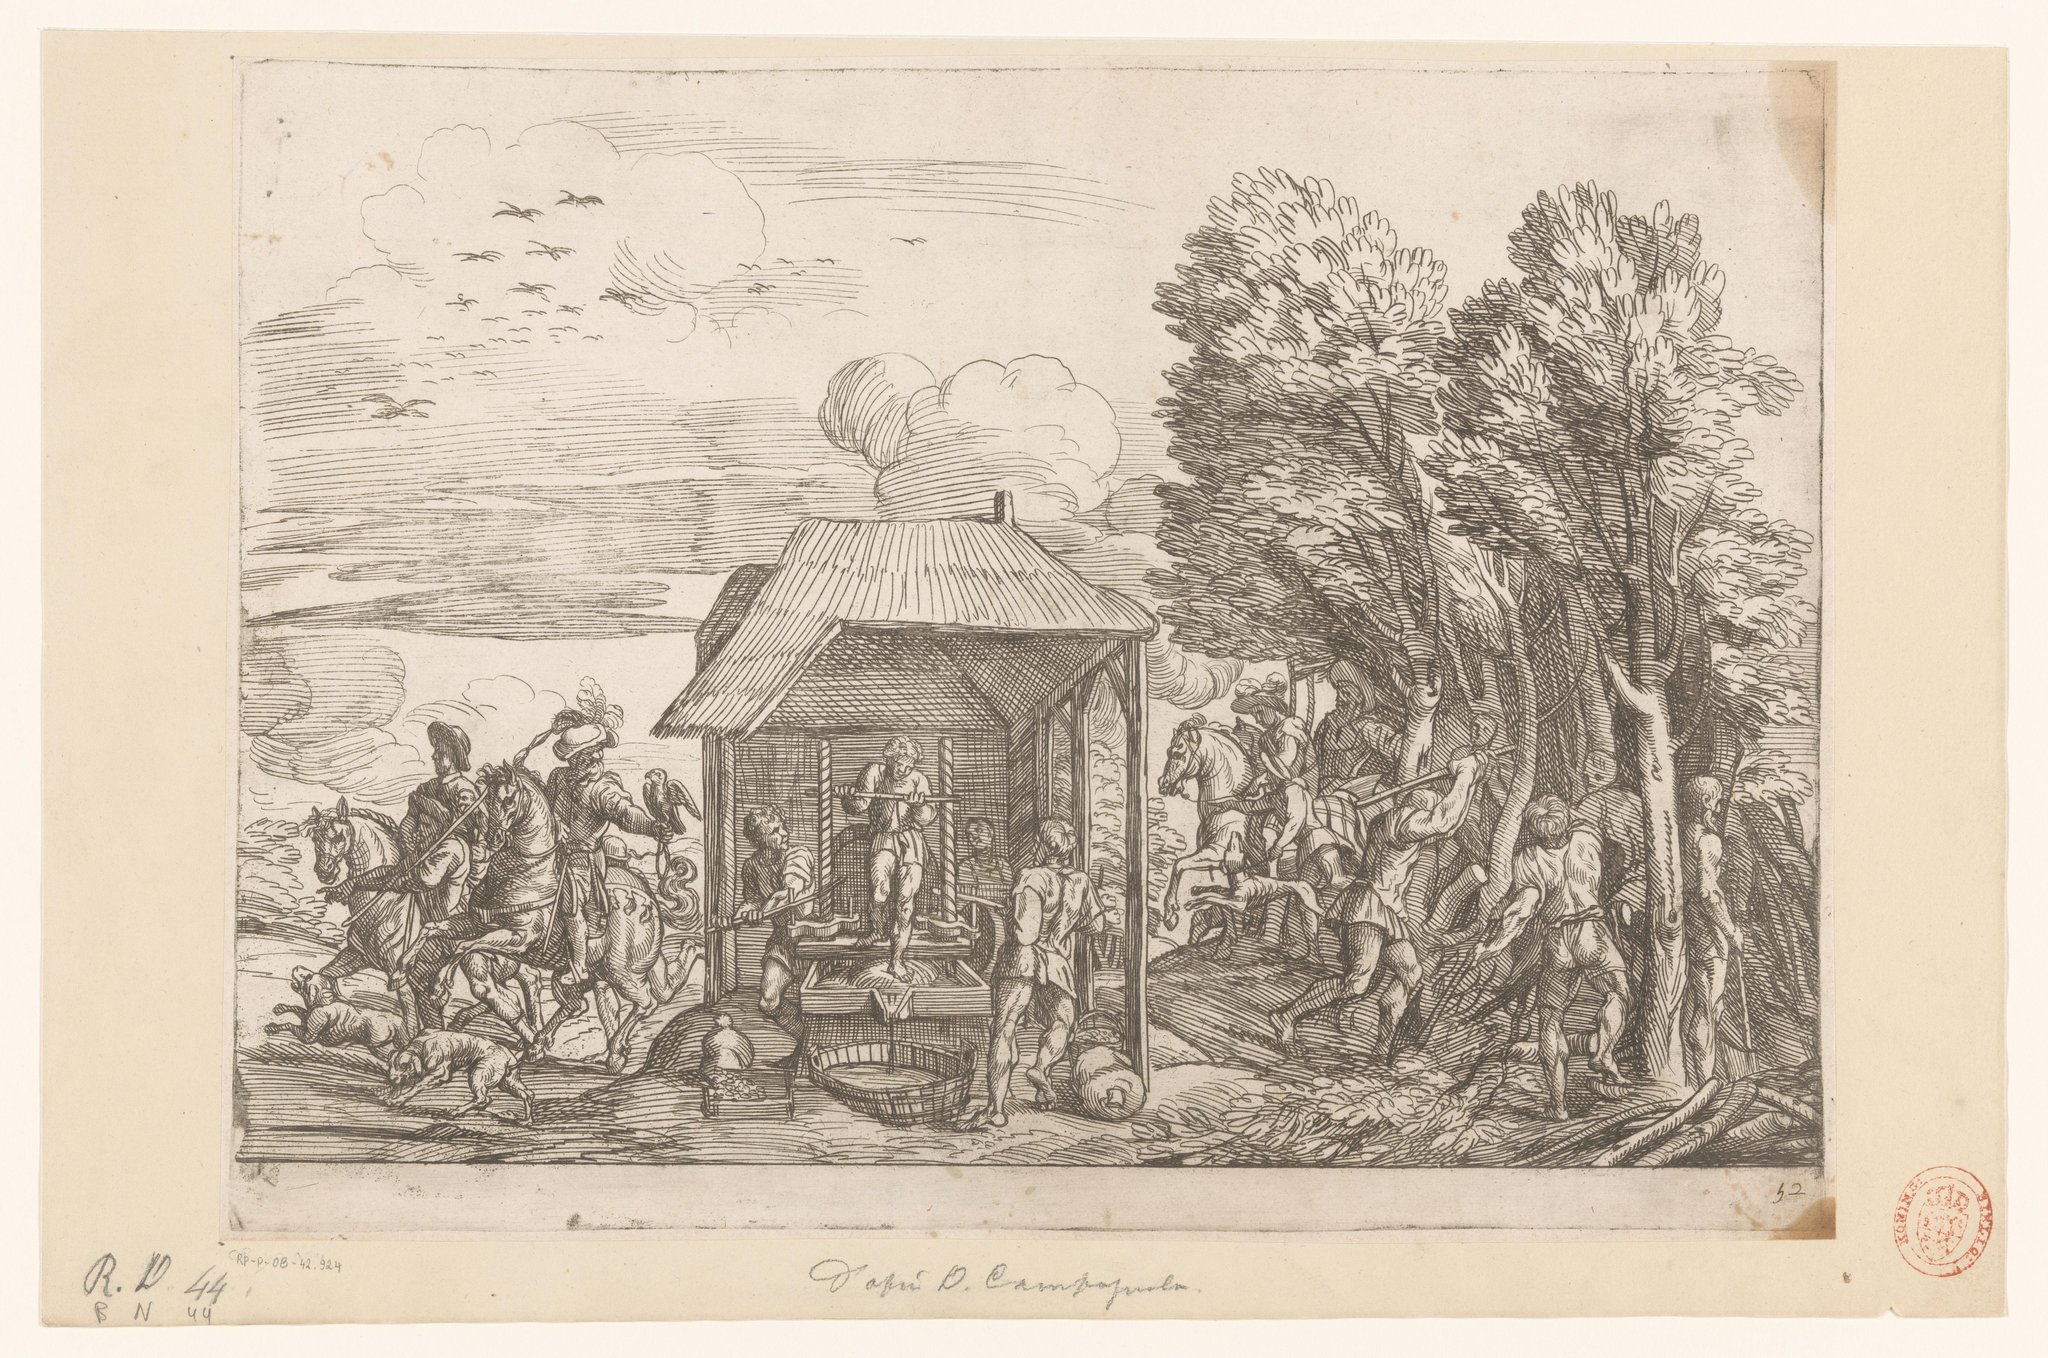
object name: print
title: Prenten naar tekeningen uit het kabinet Jabach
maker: michel corneille (ii)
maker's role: painter, print maker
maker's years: 1642-1708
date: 1652-1708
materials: paper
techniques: engraving, etching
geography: france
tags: tools, aids, implements ~ crafts and industries: press, woodcutting, woodcutter ~ forestry, hunters hunting (n.b.: in 1988-1990 this notation denoted the concept of 43c11421 'hunters resting during the hunt')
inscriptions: collector's mark: Lugt 240